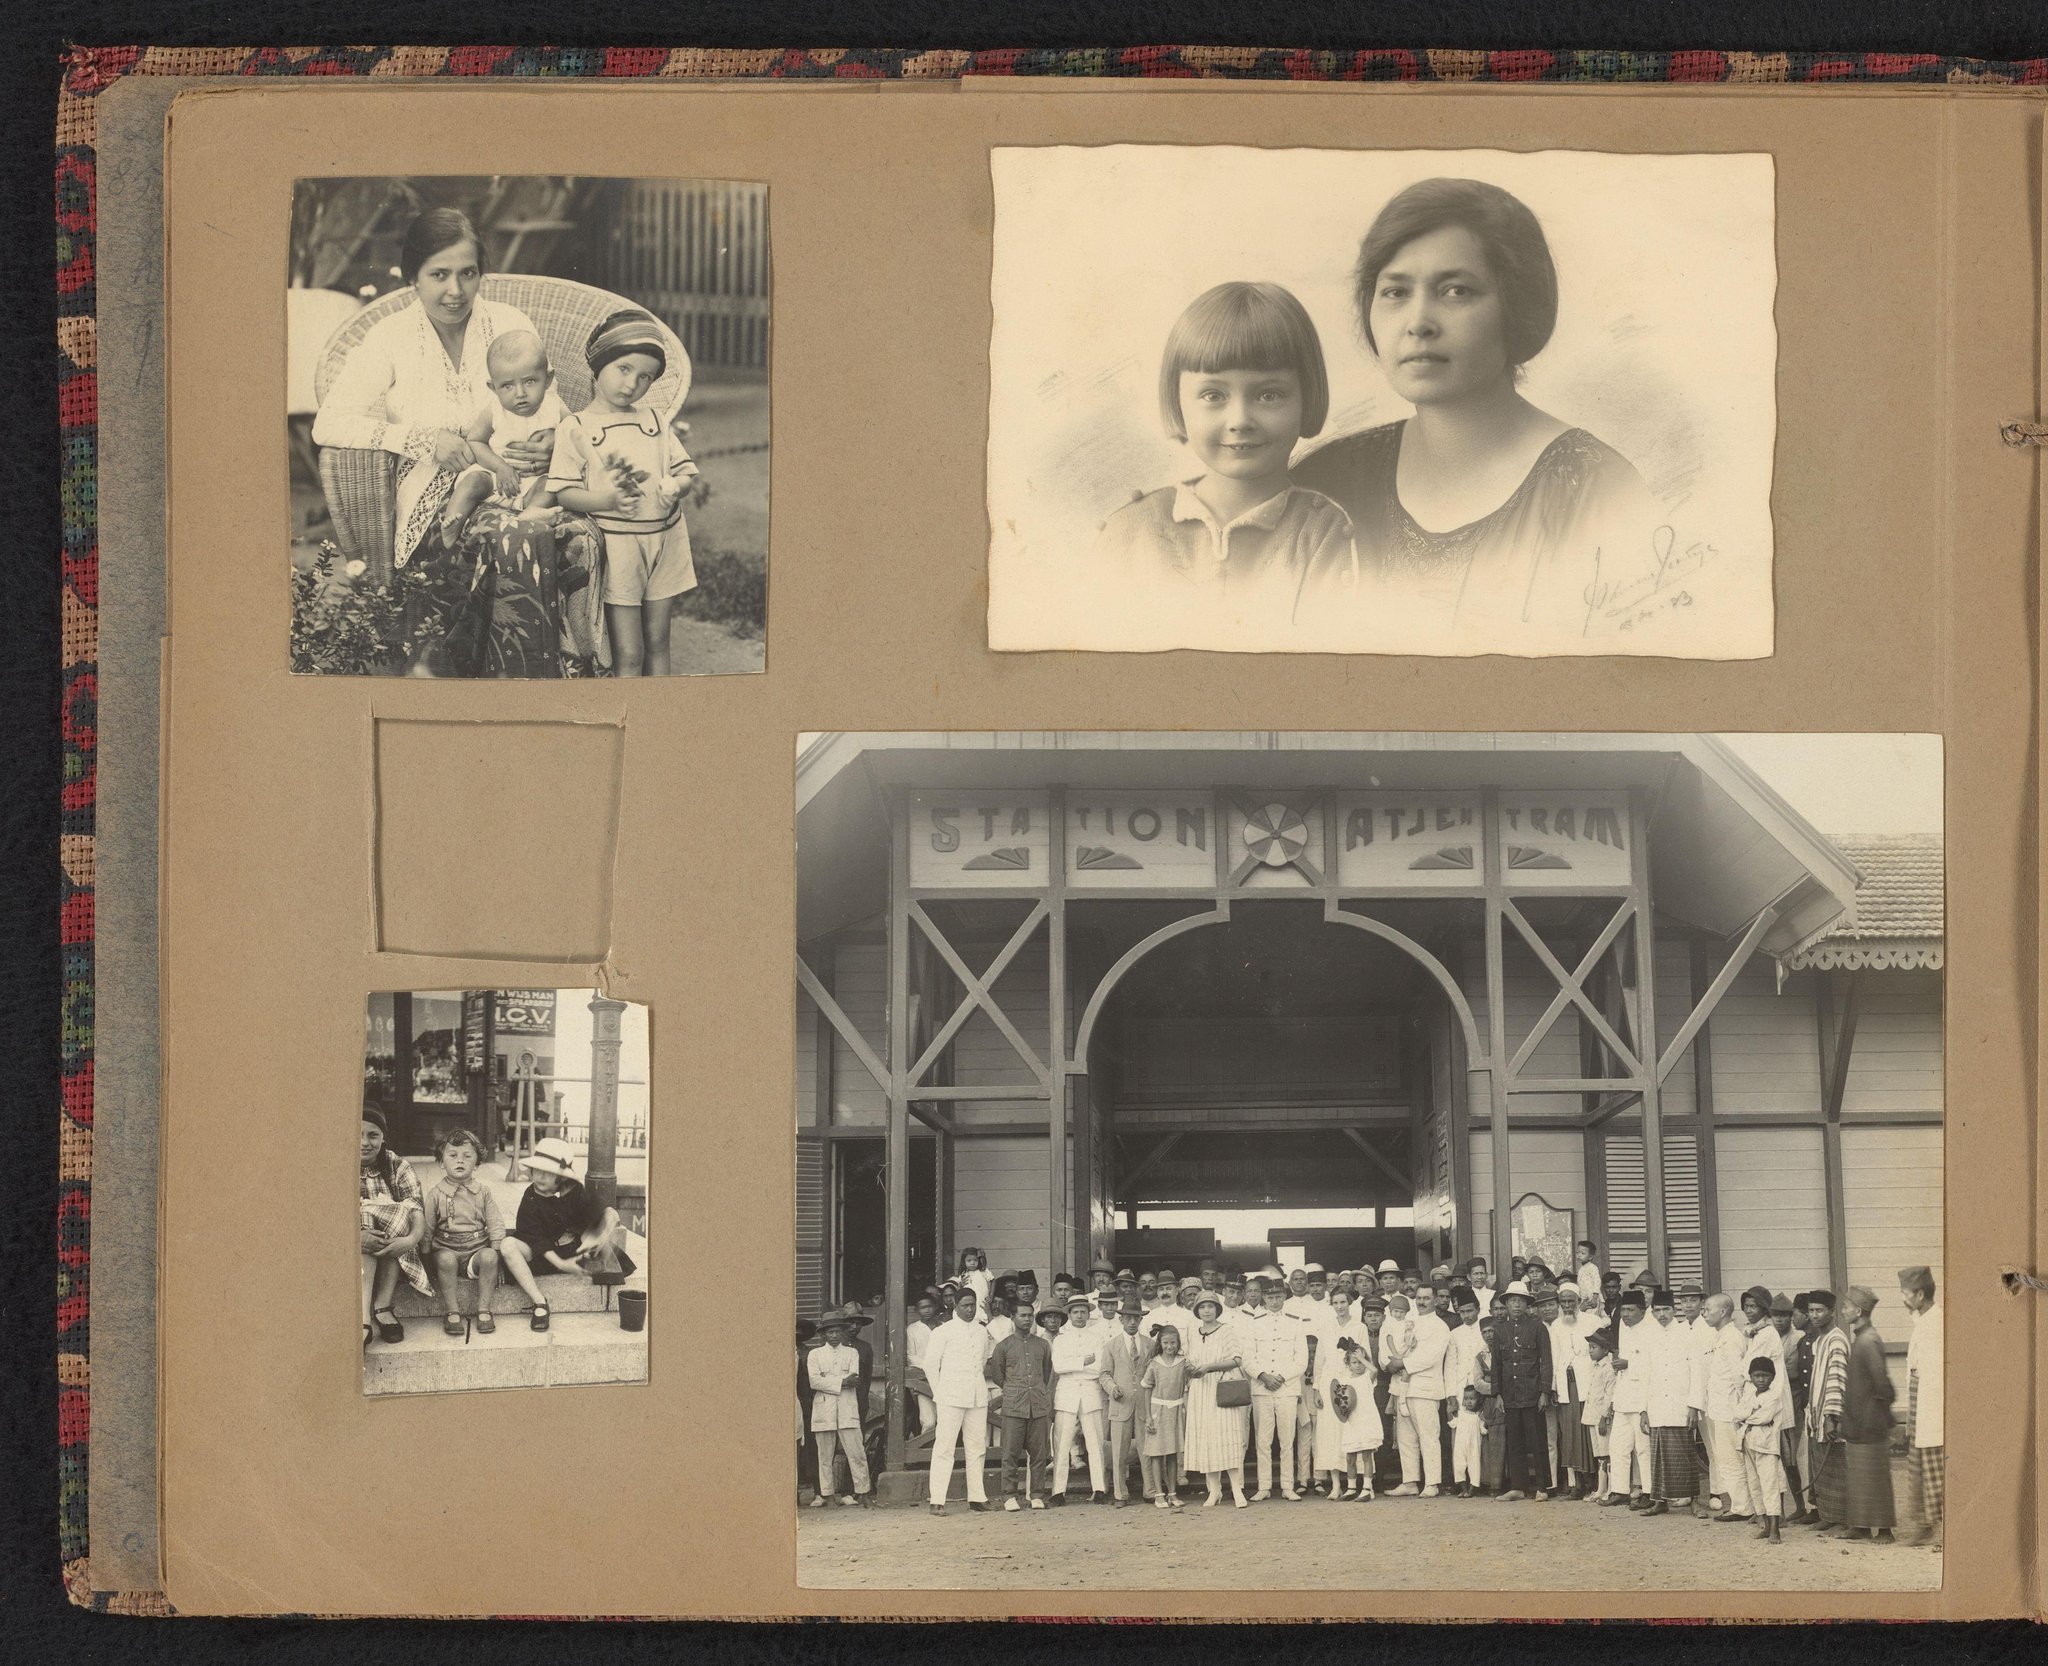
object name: photograph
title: Blad met familiefoto's en ceremonie Atjeh Tram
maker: Anonymous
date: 1920-1927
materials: cardboard, photographic support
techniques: gelatin silver print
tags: amsterdam, max nord, tramway, tram, family life at home, netherlands, dutch east indies, the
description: Albumblad met vier foto's, twee van kinderen met een Indische vrouw (moeder?). Onderaan een grote foto van de ceremoniele opening op een station van de Atjeh Tram. Onderdeel van het fotoalbum van mevr. Nord-Elshout, de oma van de schenkster Emilie Nord (moeder van Max Nord), met foto's van familieleven uit de periode 1920-1927 in Nederlands-Indië en Nederland.